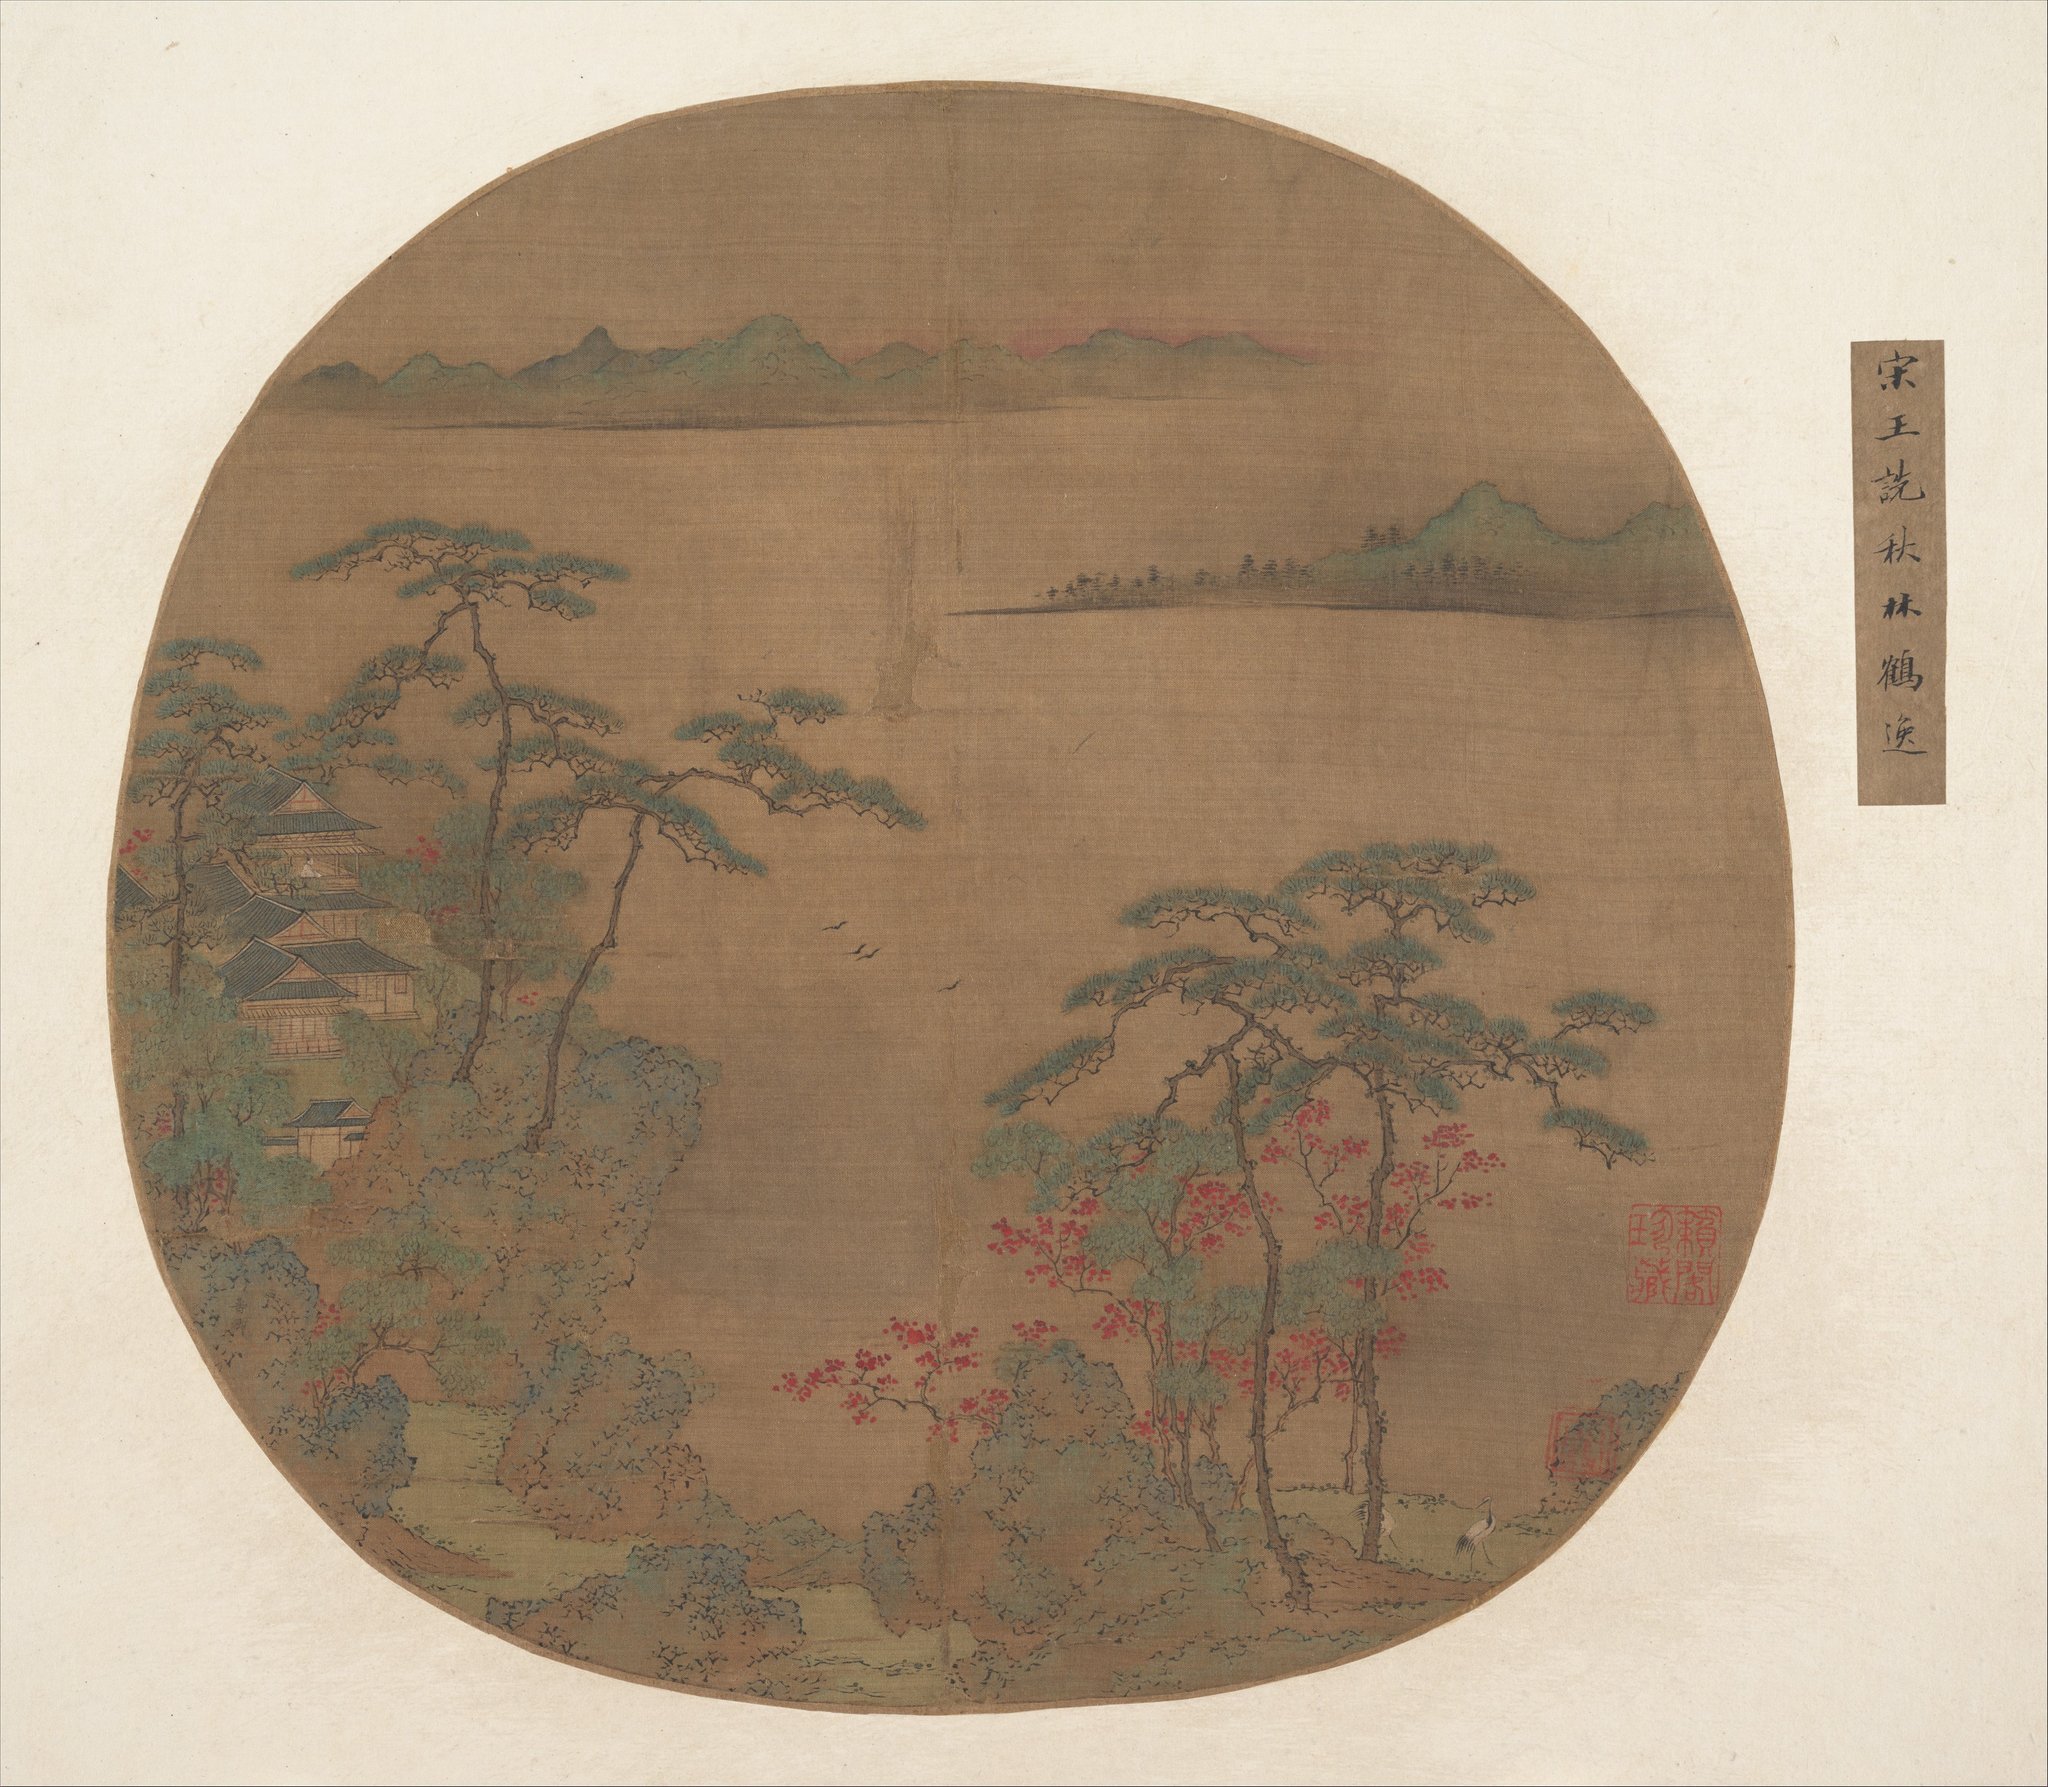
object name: fan mounted a an album leaf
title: Landscape with Pavilions and Cranes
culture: chinese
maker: unidentified artist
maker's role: artist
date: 1271-1644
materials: ink, silk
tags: cranes,landscapes